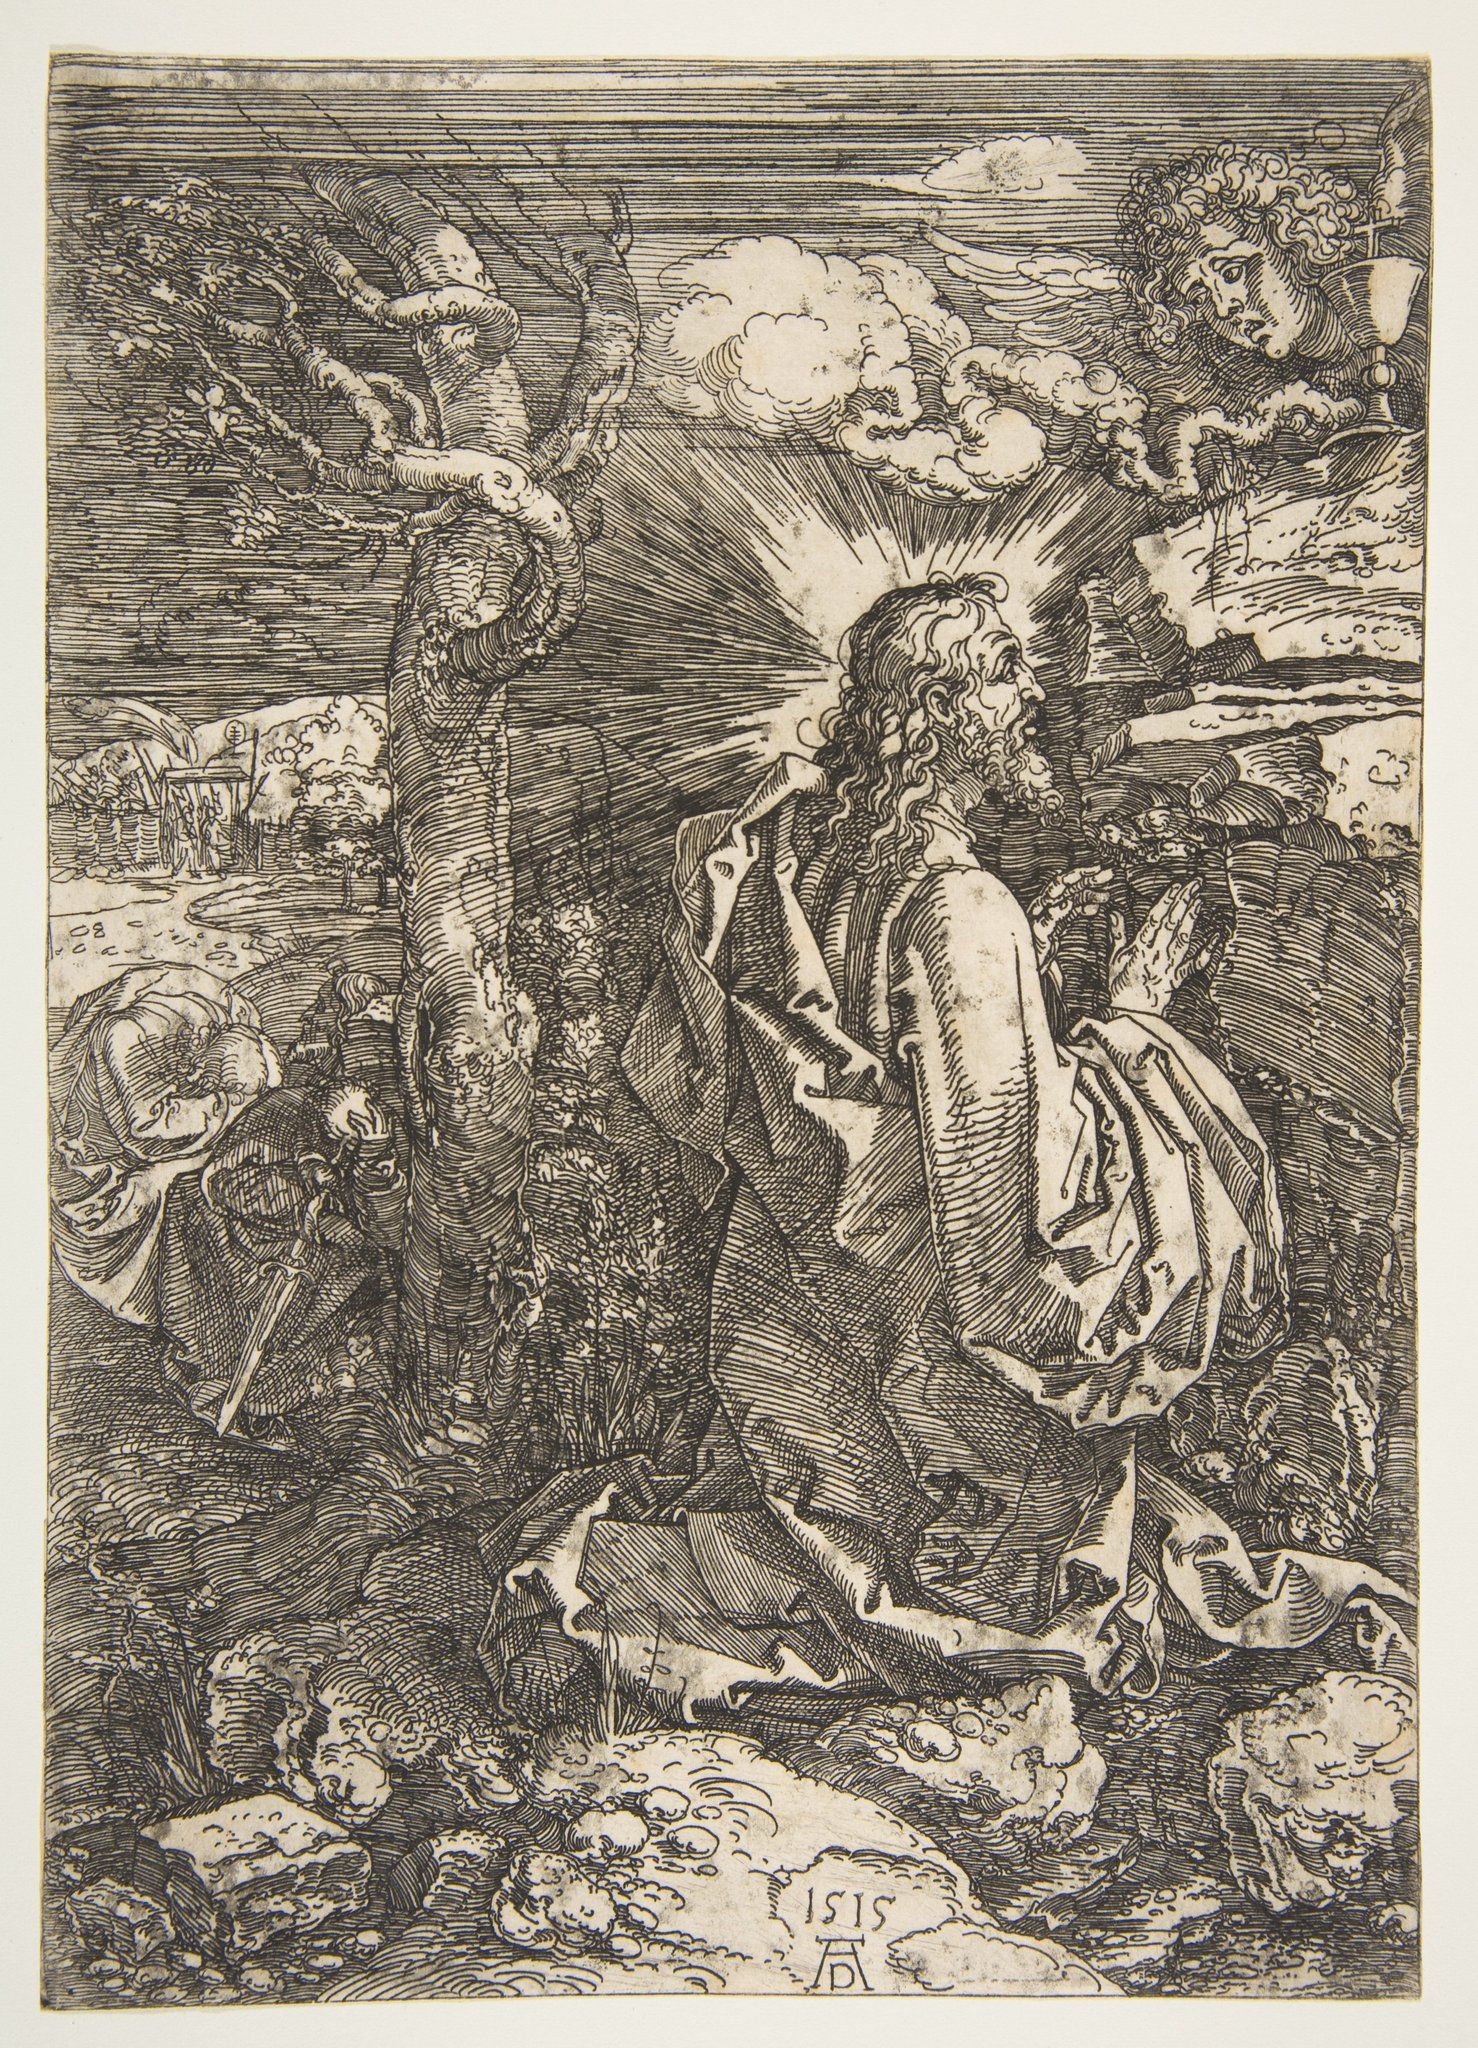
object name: print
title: Agony in the Garden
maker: albrecht dürer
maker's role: artist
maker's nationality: german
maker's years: 1471-1528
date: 1515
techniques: etching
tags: gardens,trees,angels,christ